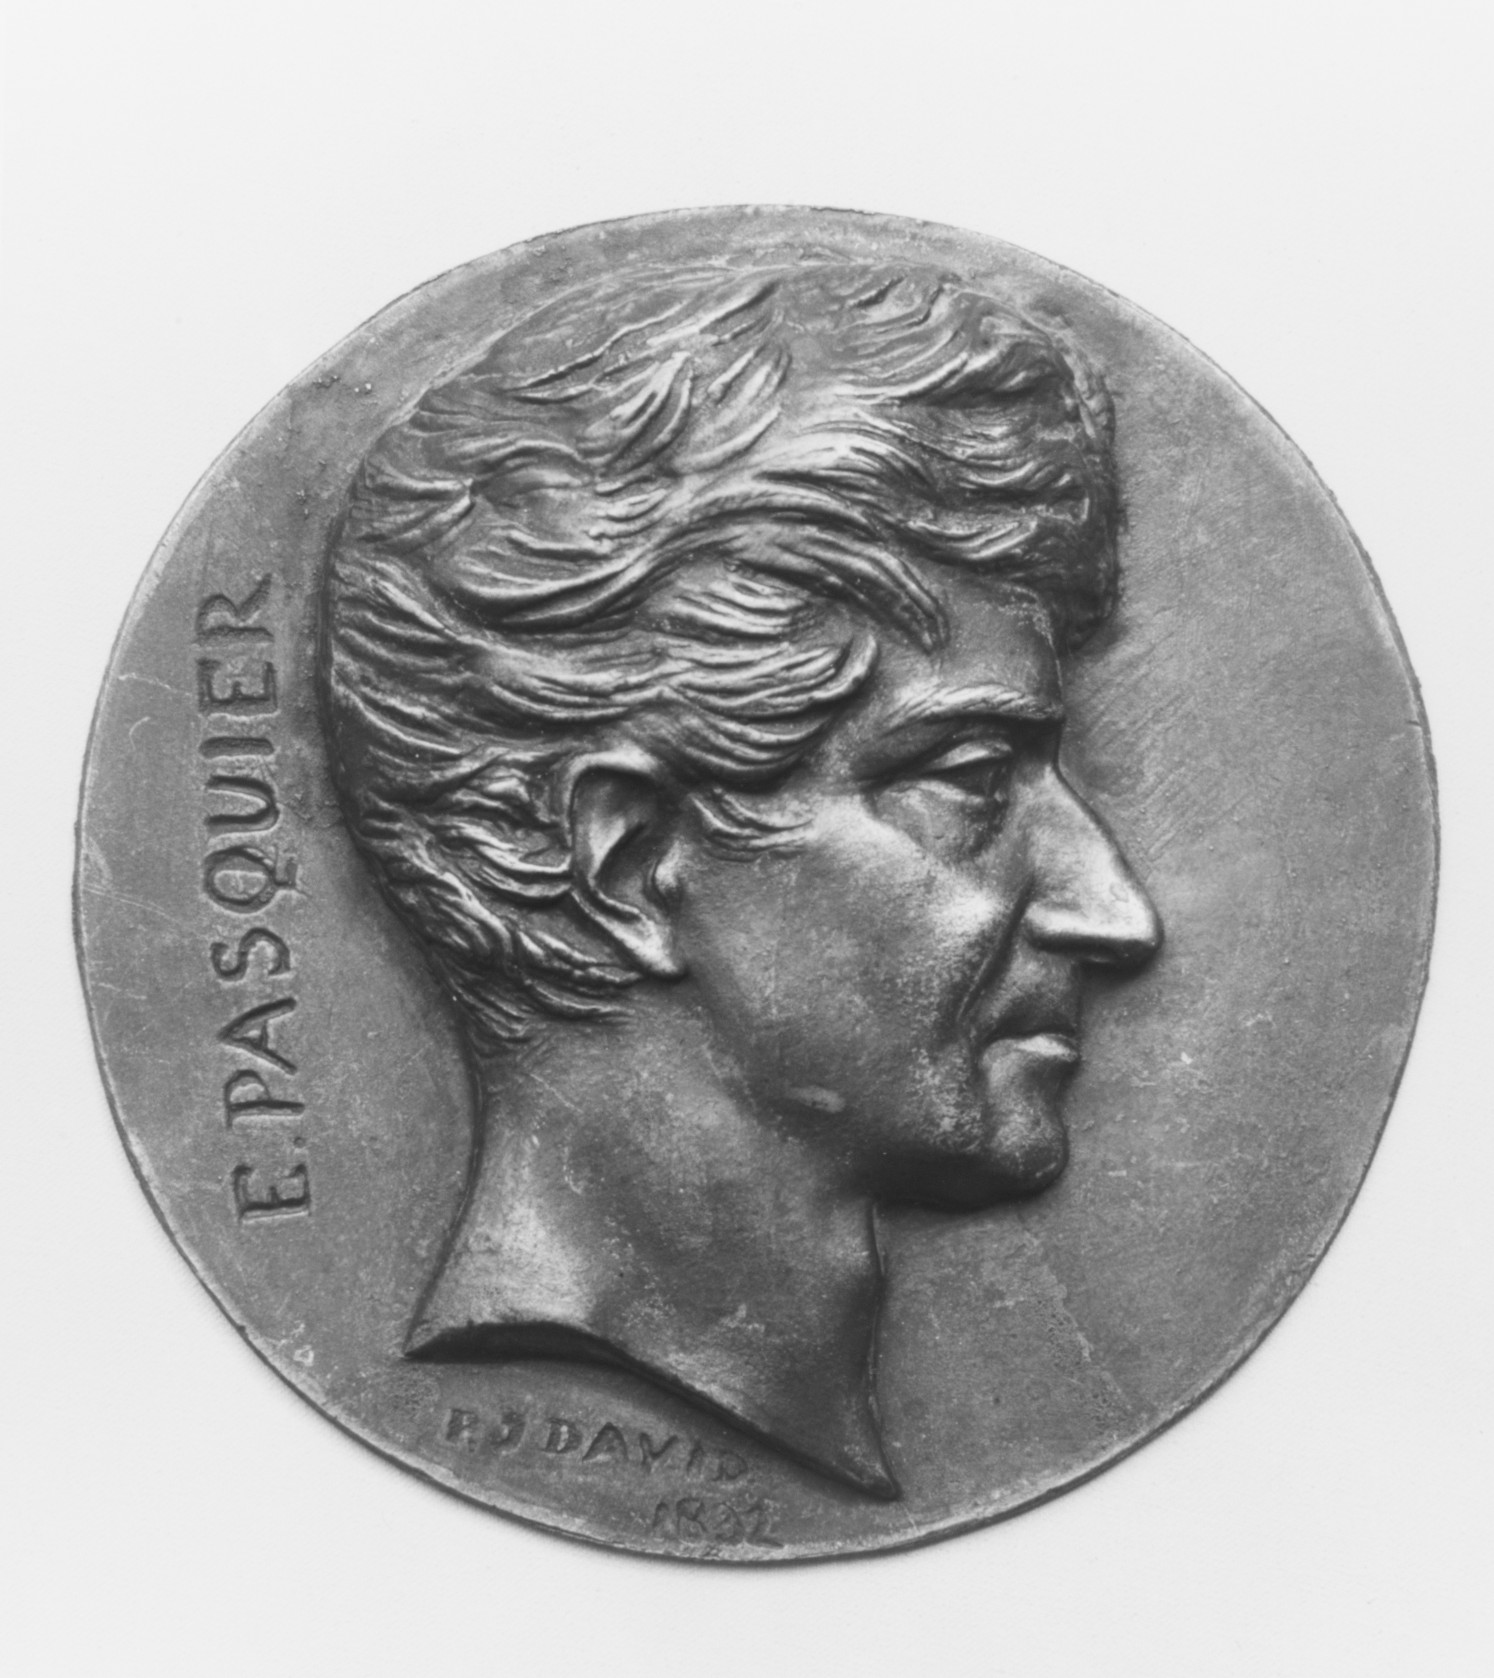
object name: medallion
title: Êtienne Denis, Duc de Pasquier (1767–1862), French statesman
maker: pierre jean david d'angers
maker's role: artist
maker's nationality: french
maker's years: 1788-1856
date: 1832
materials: bronze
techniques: casting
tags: men,profiles